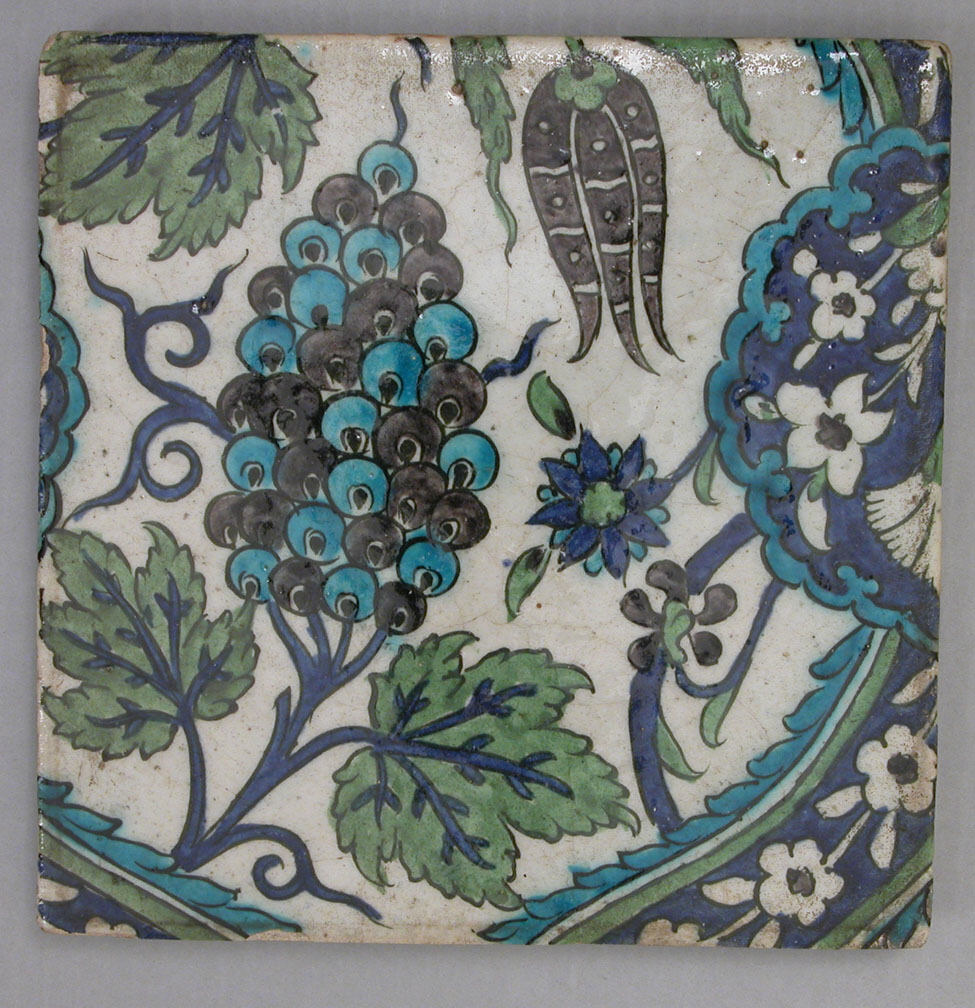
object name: tile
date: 1567-1633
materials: paste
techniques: glazing, painting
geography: syria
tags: grapes